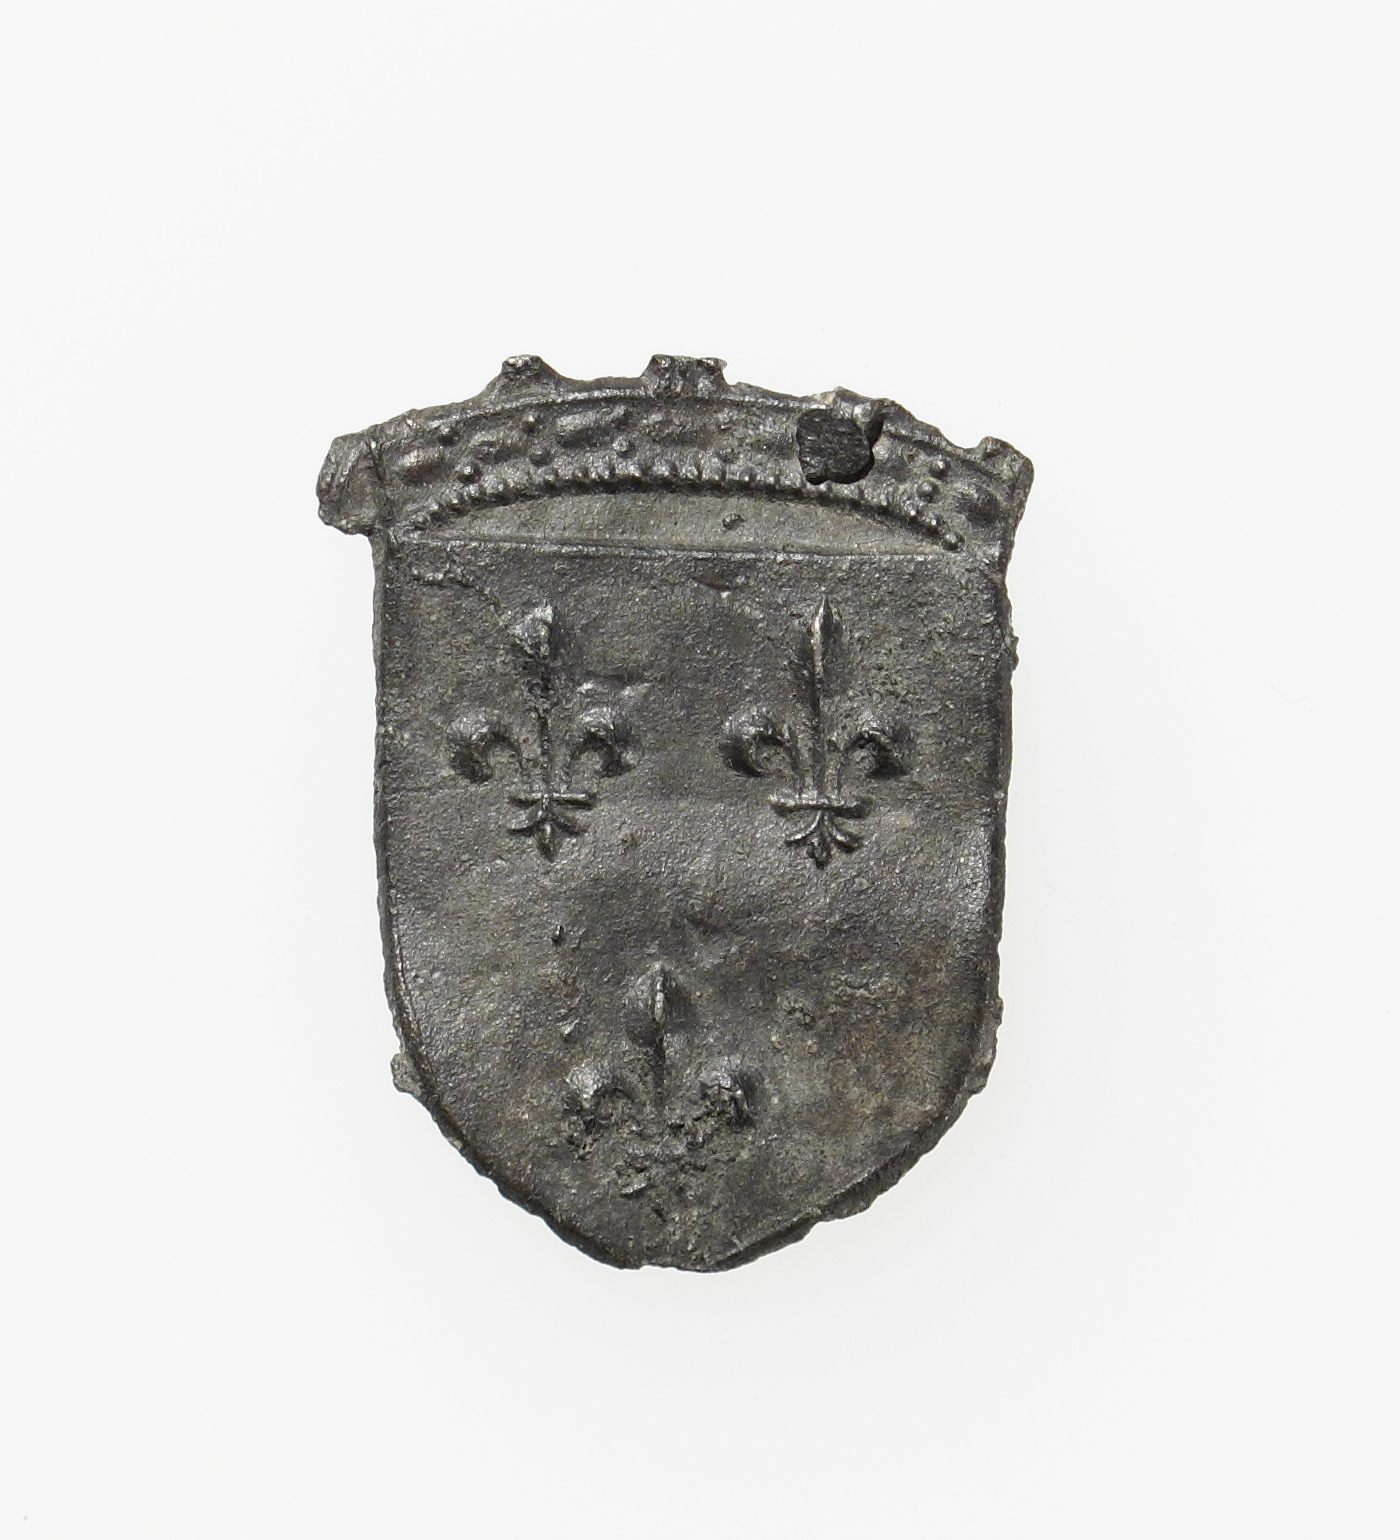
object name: pilgrim's badge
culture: french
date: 1301-1600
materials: lead